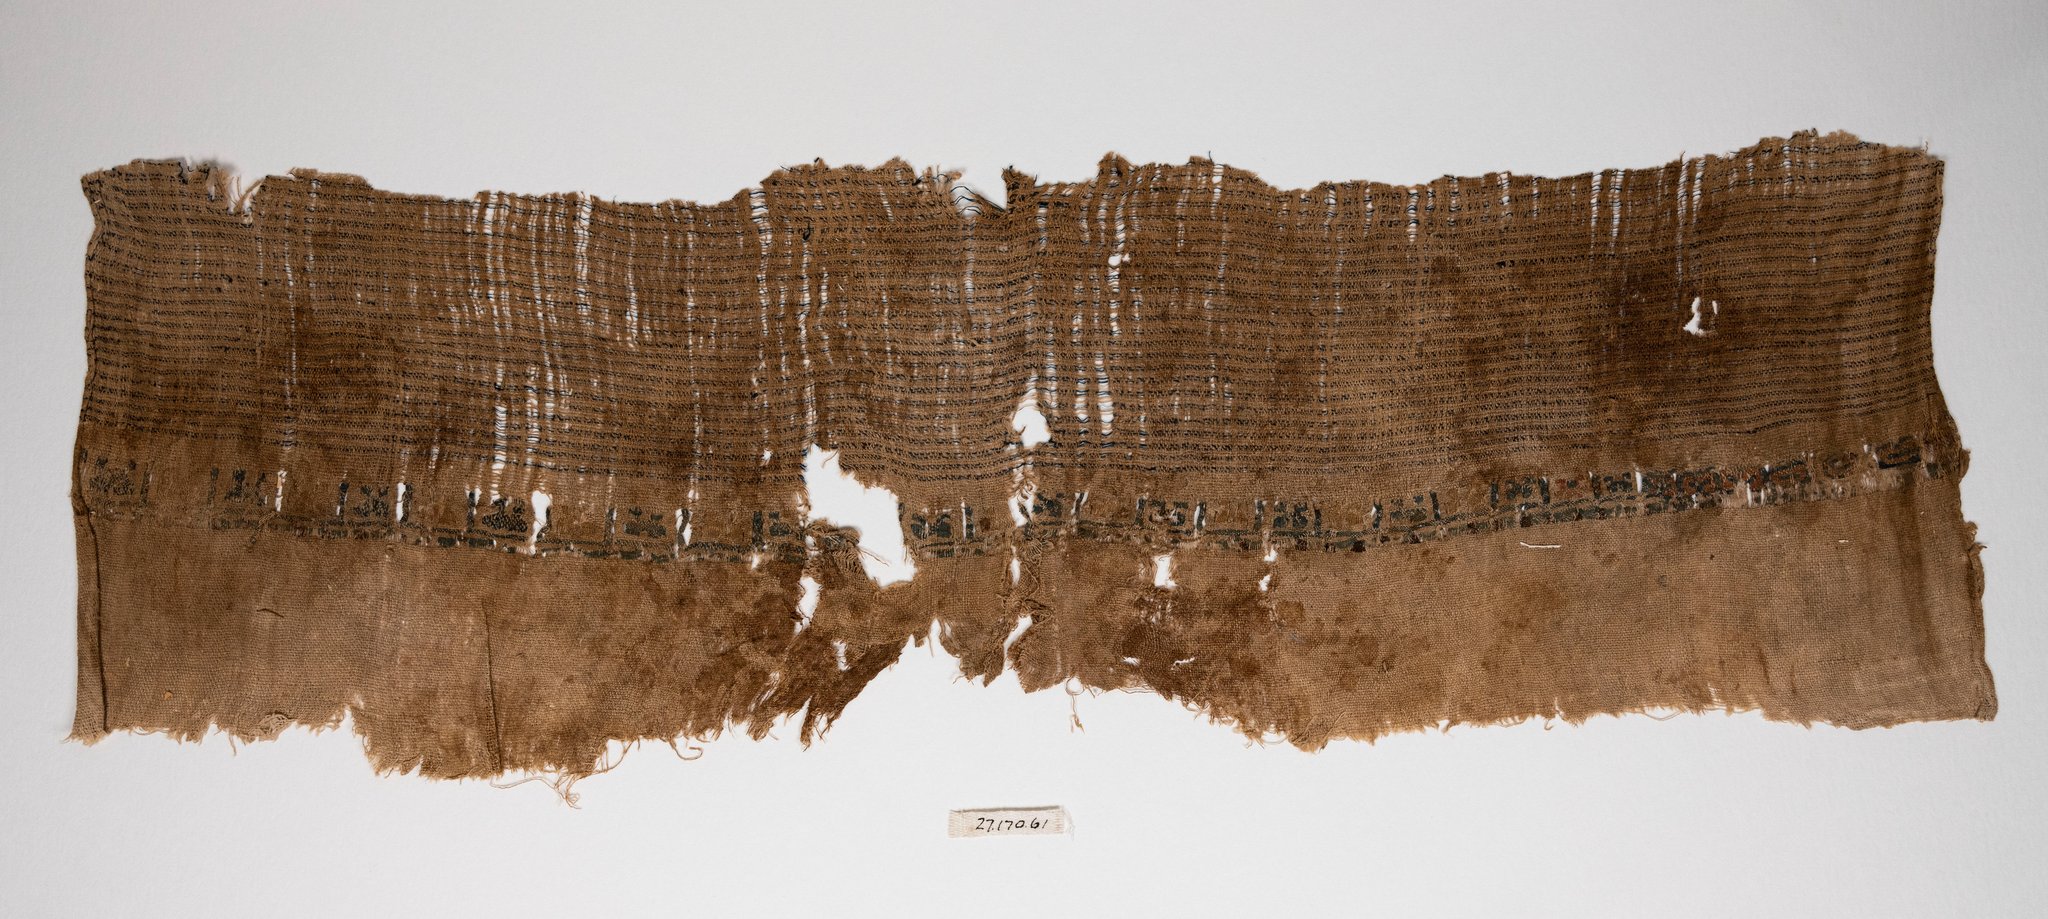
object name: textile fragment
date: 901-1100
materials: linen, silk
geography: egypt